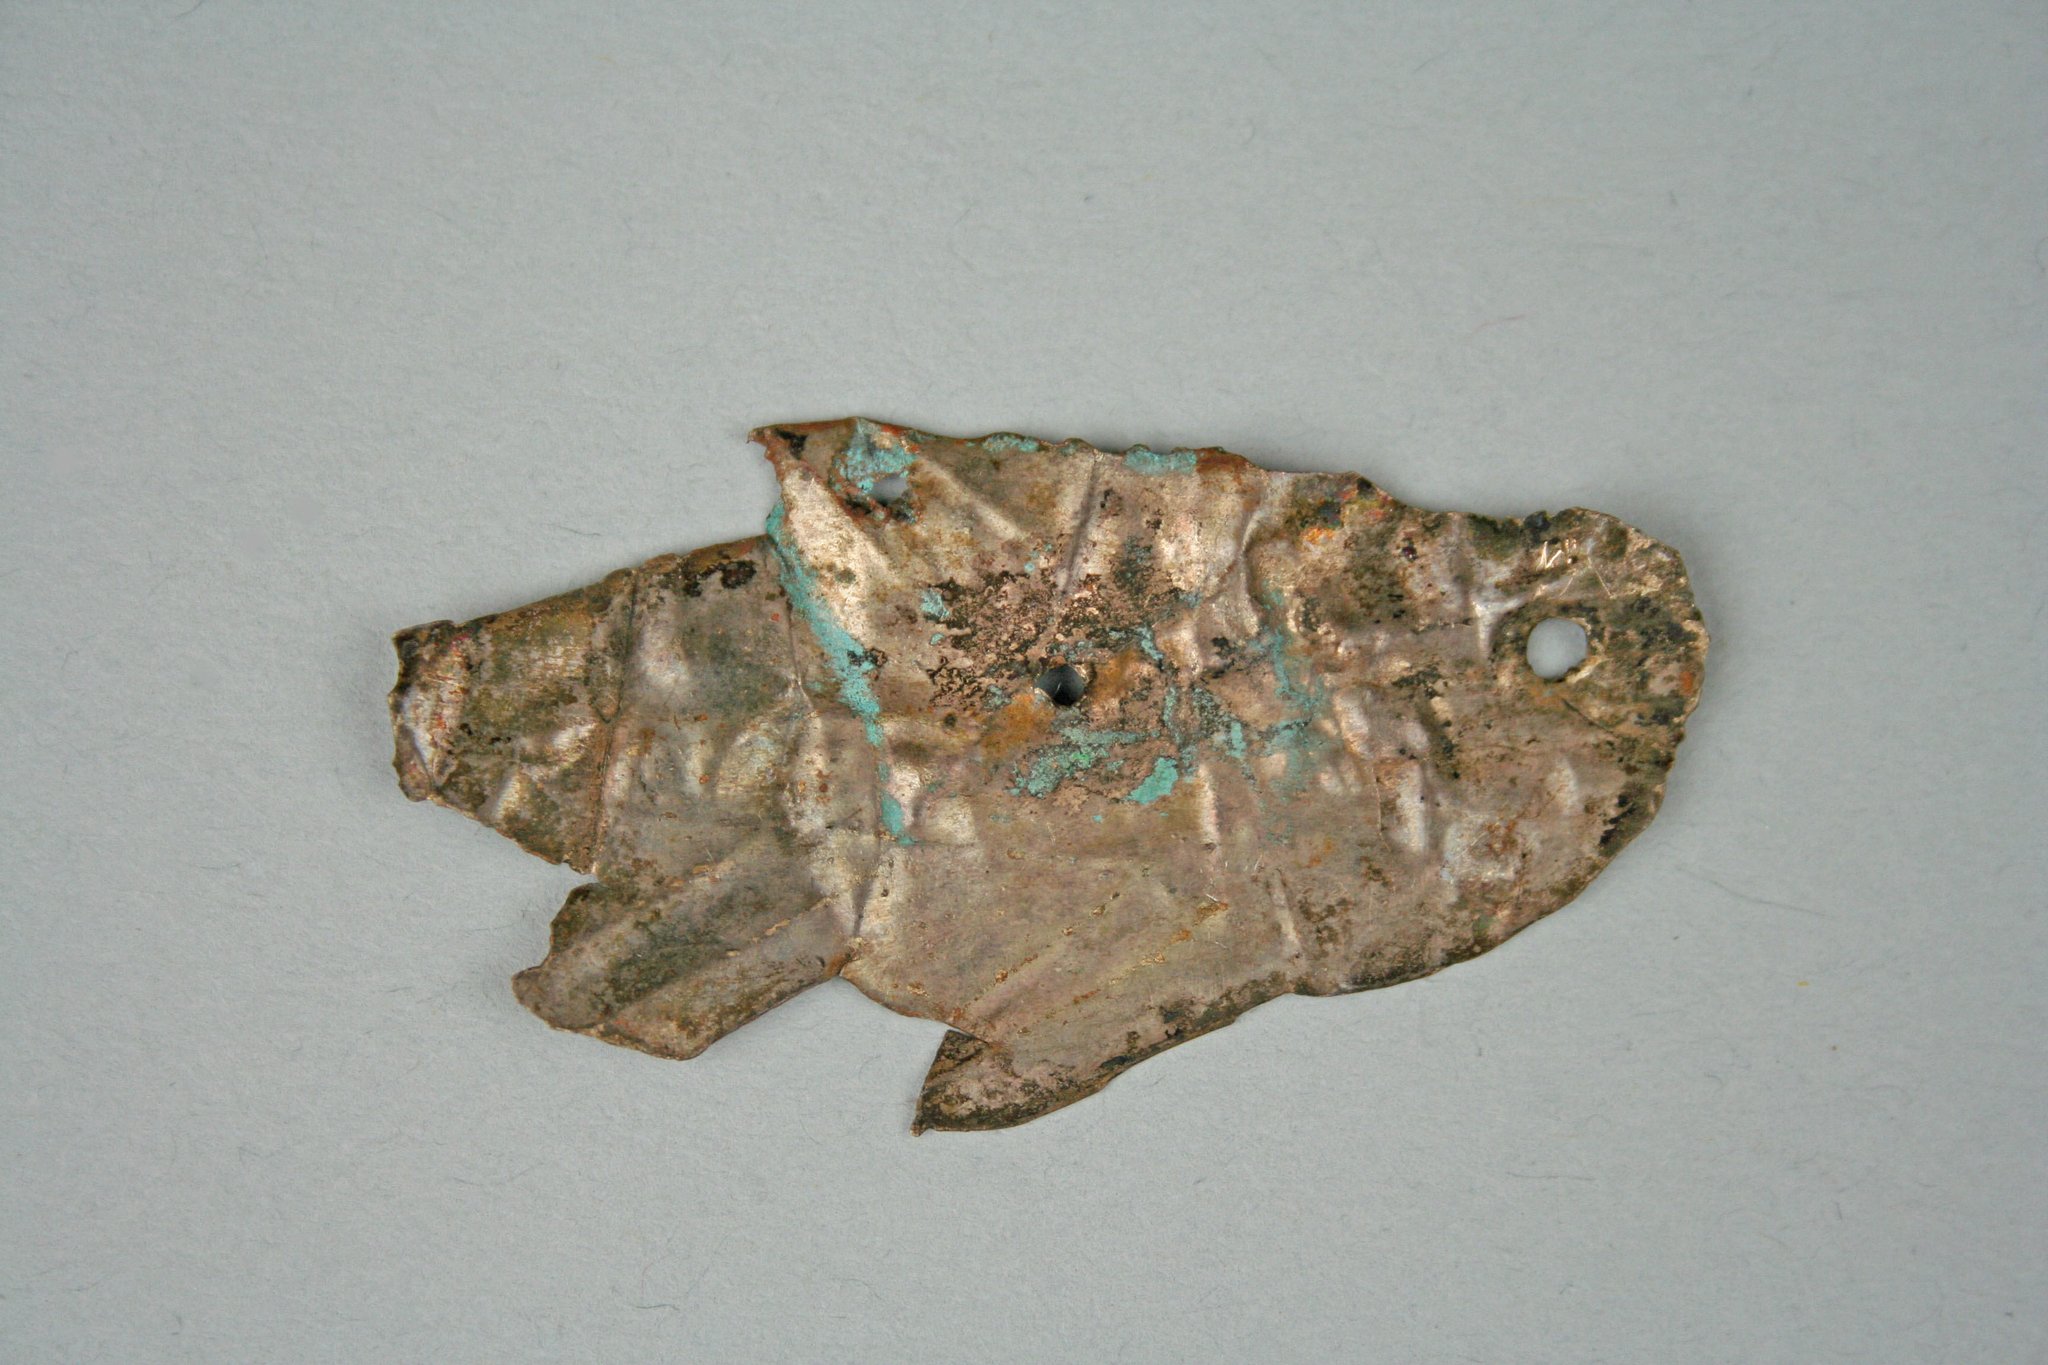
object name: ornament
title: Fish Ornament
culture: peruvian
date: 1001-1200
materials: silver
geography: peru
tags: fish